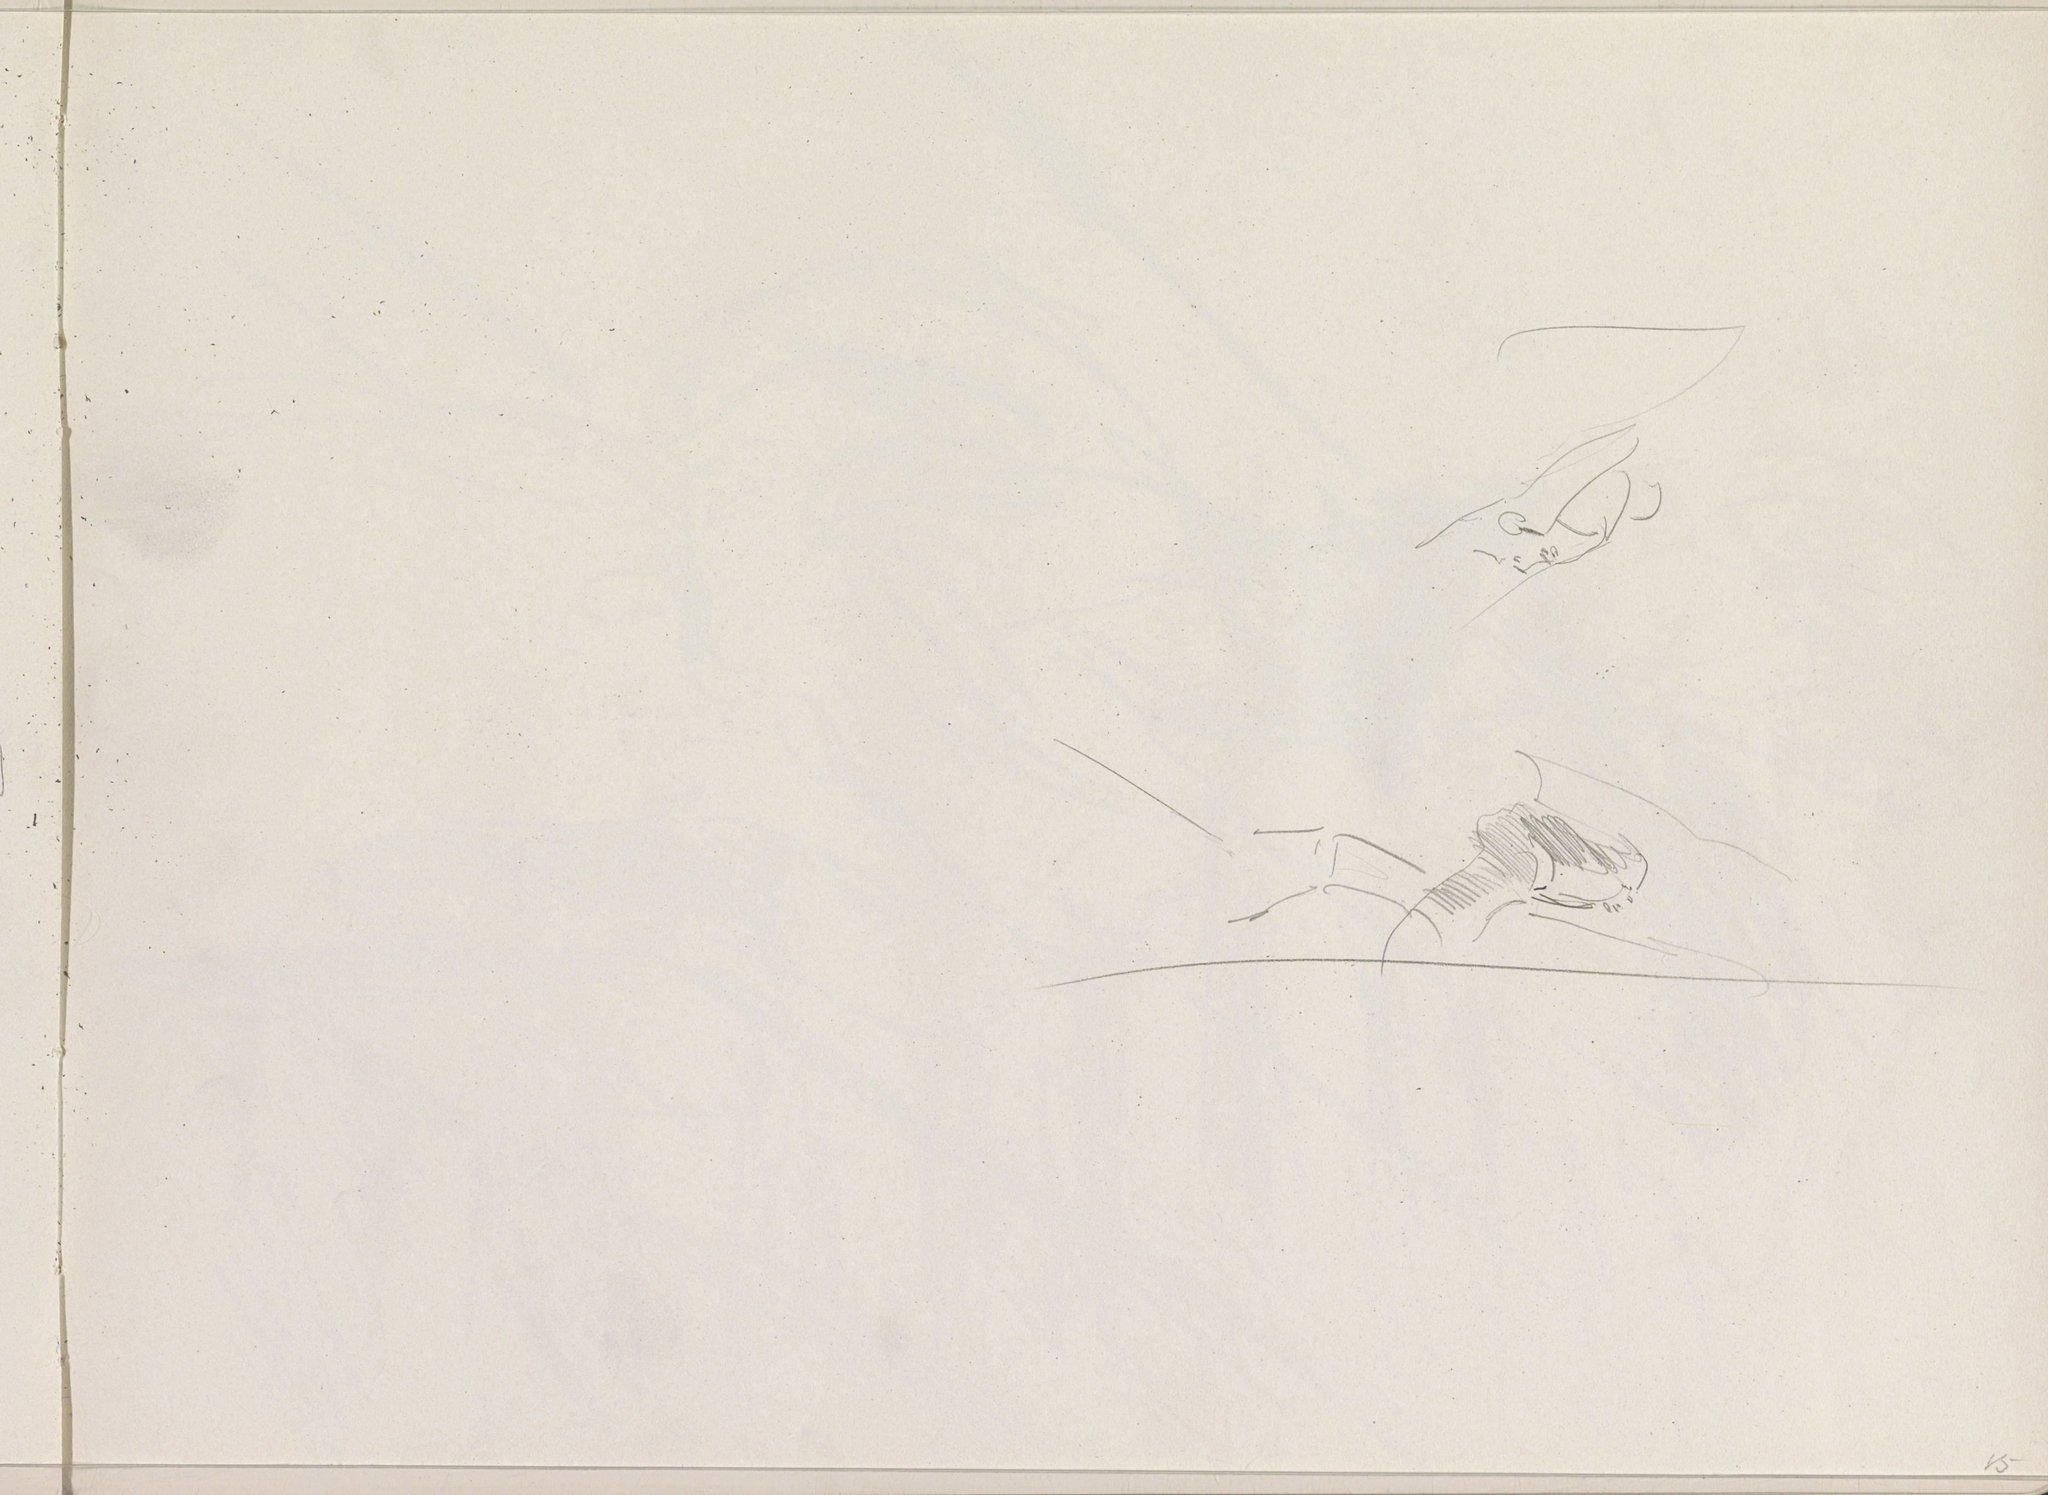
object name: sketchbook leaf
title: Twee vrouwen met hoofdtooien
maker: isaac israels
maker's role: draughtsman, painter, print maker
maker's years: 1865-1934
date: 1915-1934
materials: paper, pencil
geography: the hague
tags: adolescent, young woman, maiden, female dancer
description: Mogelijk danseressen. Blad 15 recto uit schetsboek III met 36 bladen.